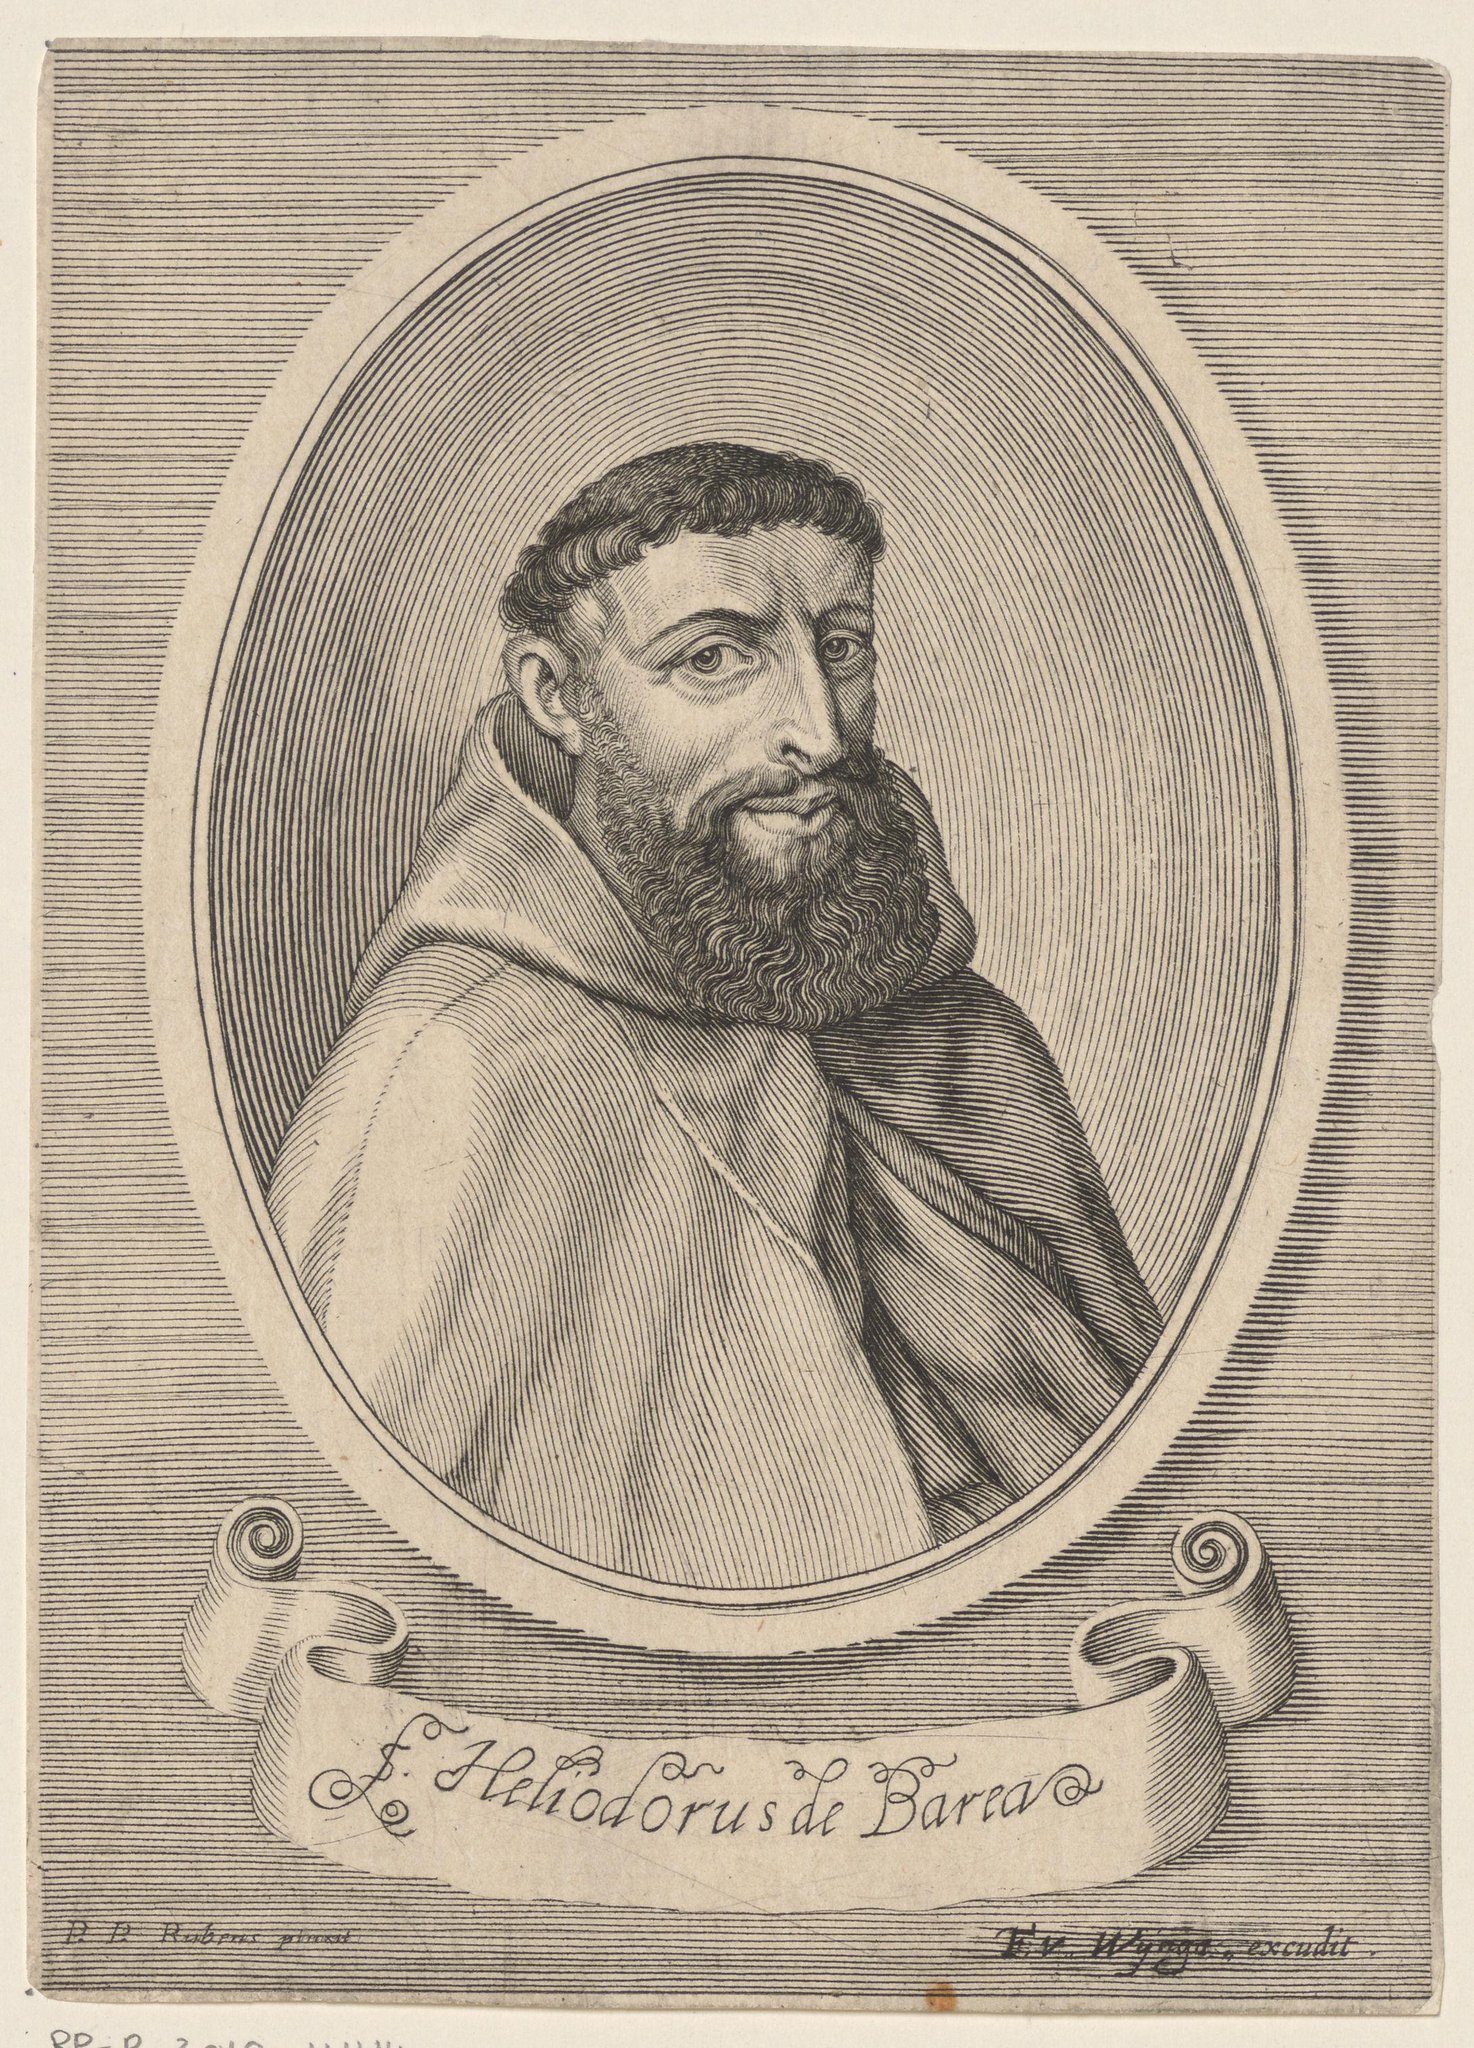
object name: print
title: Portret van Heliodorus de Barea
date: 1636-1679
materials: paper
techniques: engraving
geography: antwerp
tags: historical persons